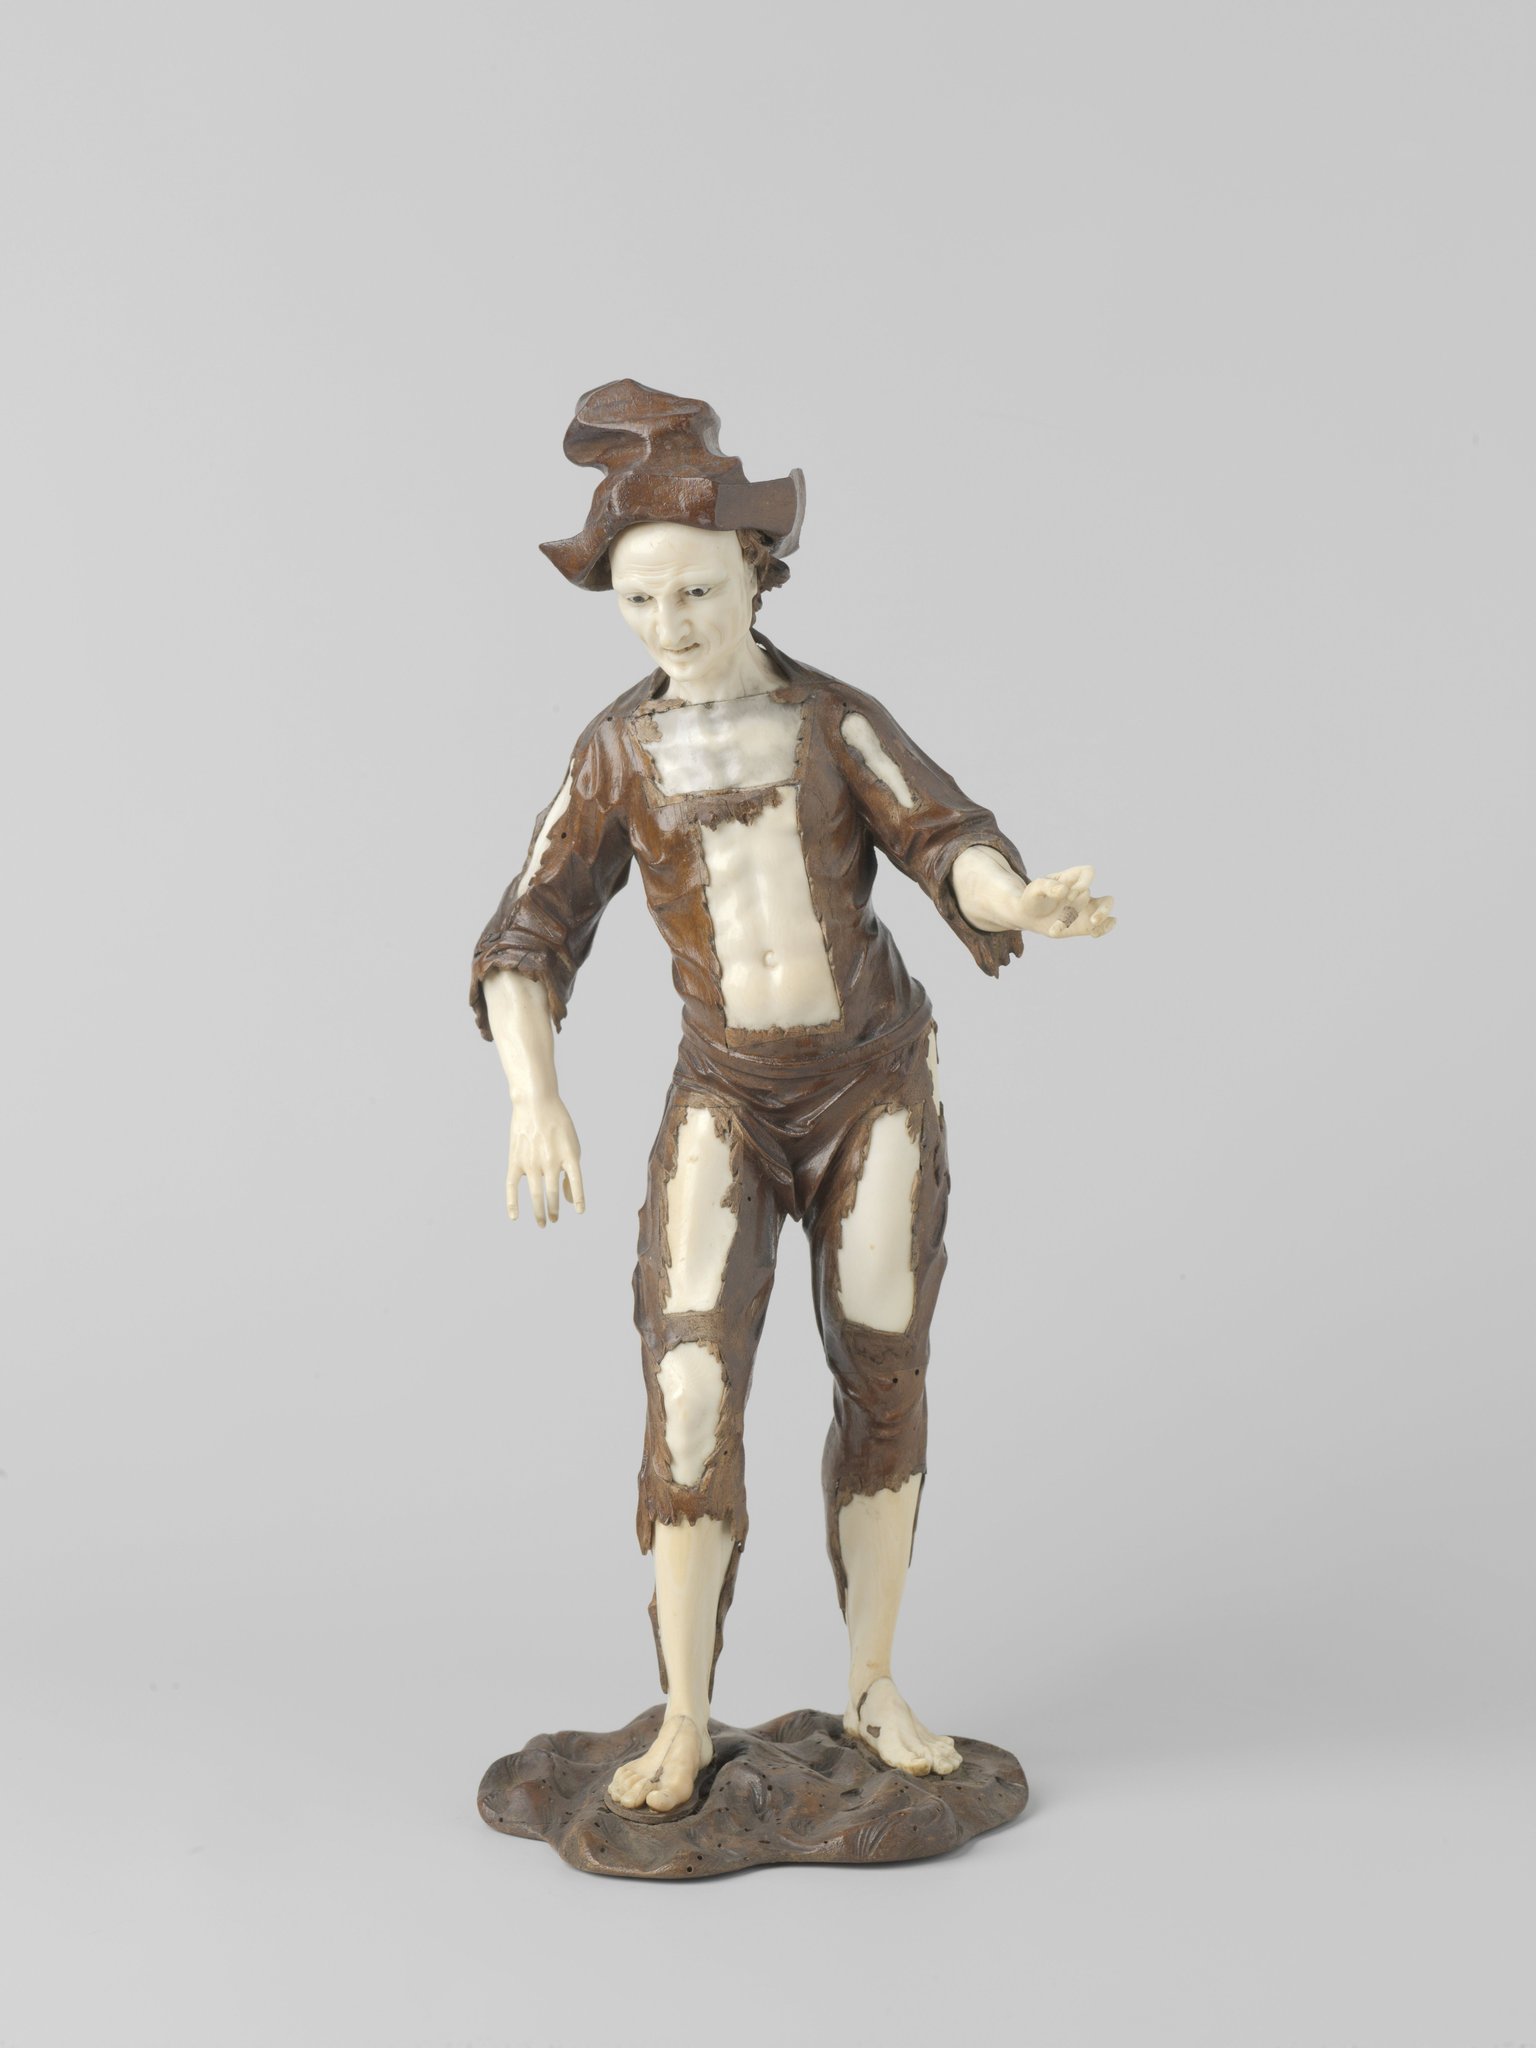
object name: sculpture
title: Bedelende figuur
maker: simon troger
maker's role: sculptor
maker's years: 1693-1768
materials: ivory